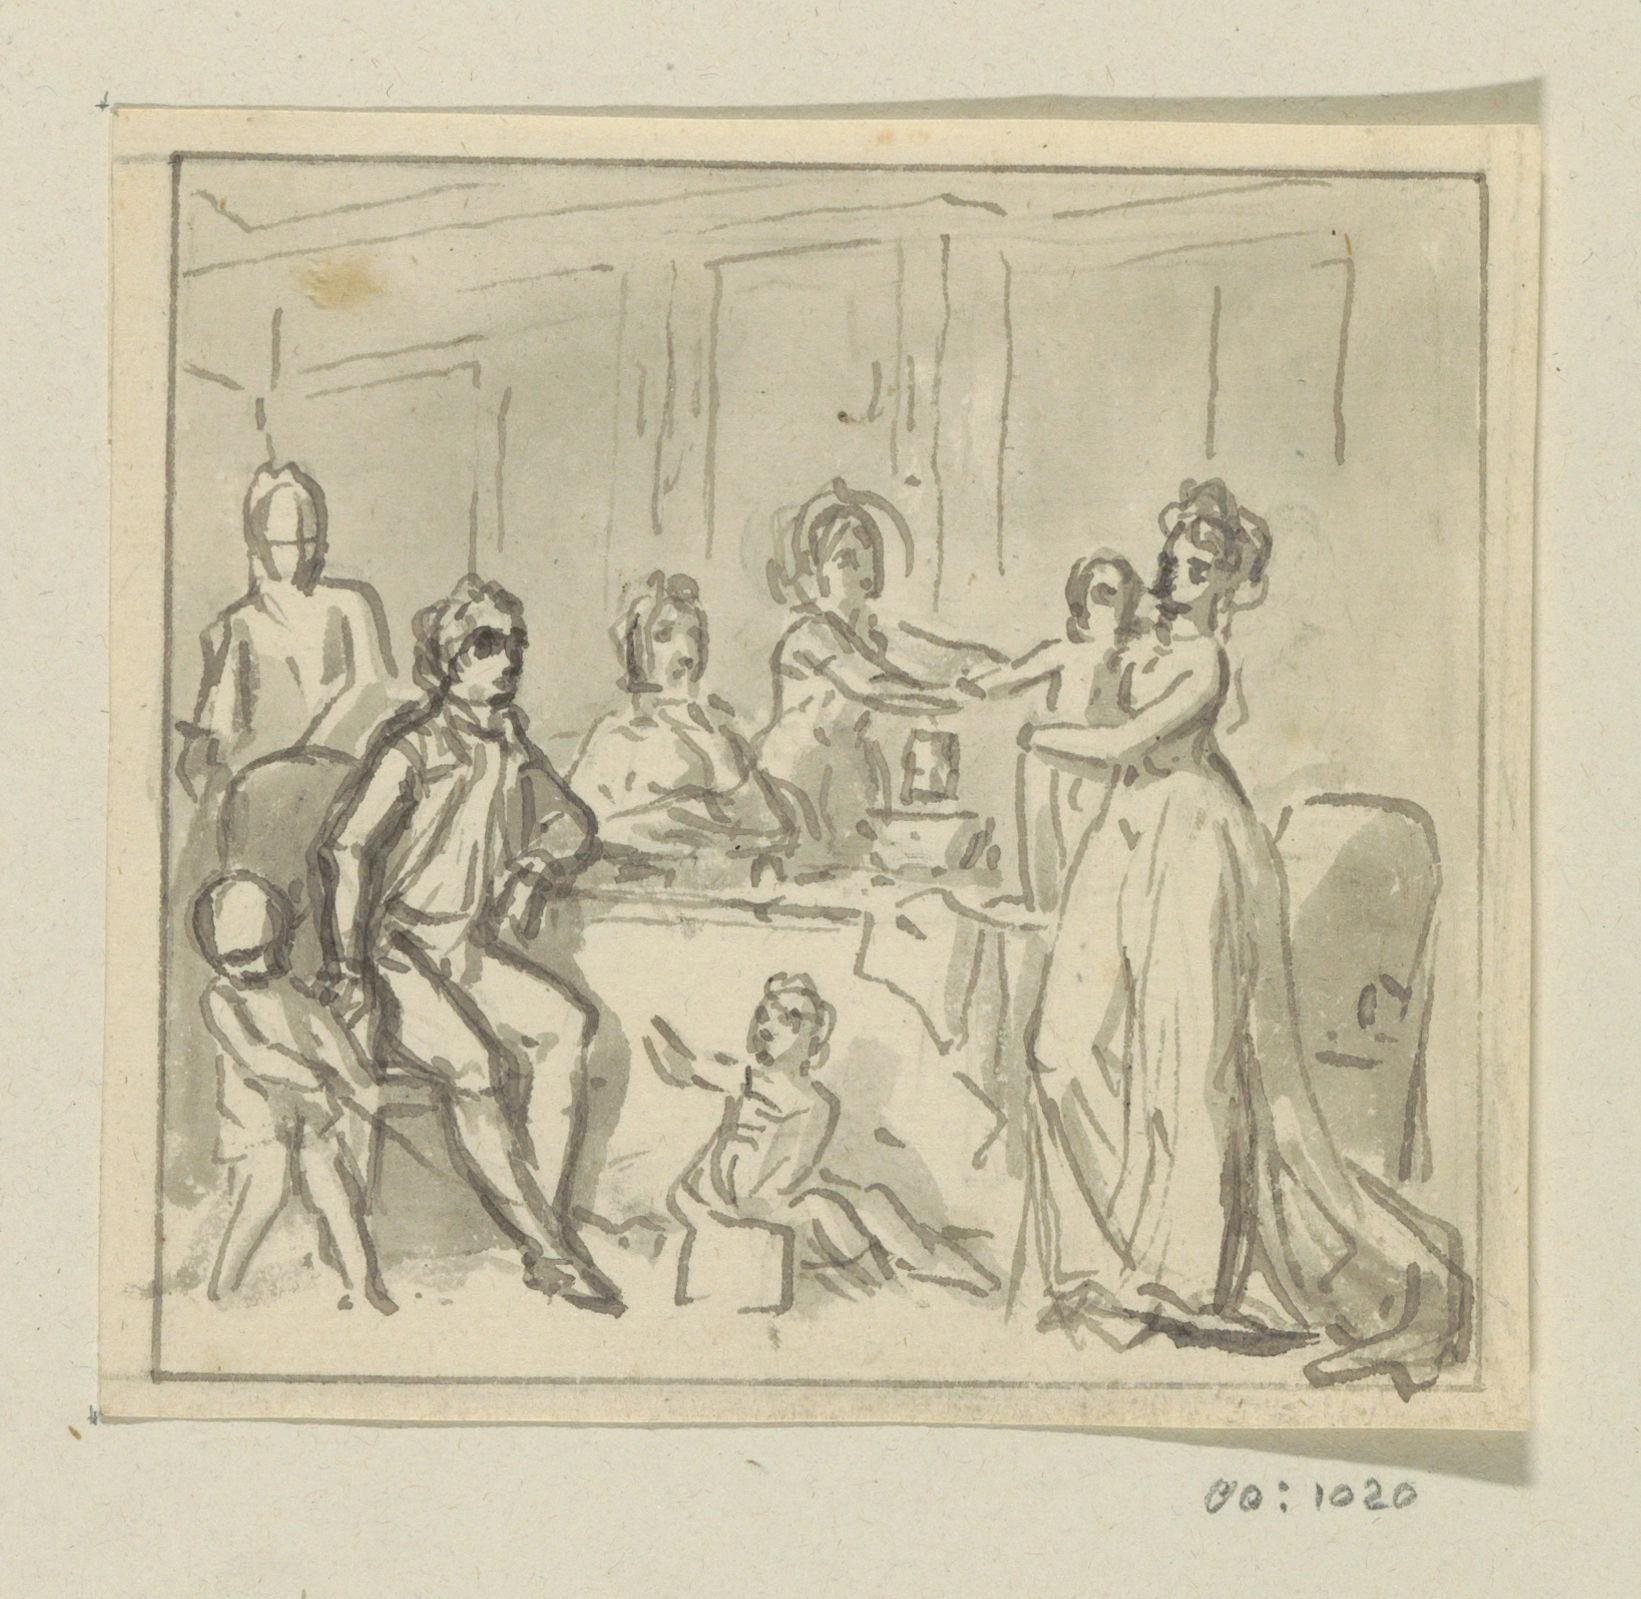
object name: drawing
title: Gezin rondom een tafel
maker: jurriaan andriessen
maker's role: draughtsman, painter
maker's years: 1742-1819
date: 1760-1819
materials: paper, pencil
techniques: brush, pen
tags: family life at home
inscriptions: inscription: ‘Familie[?] stuk/ voor Levi’